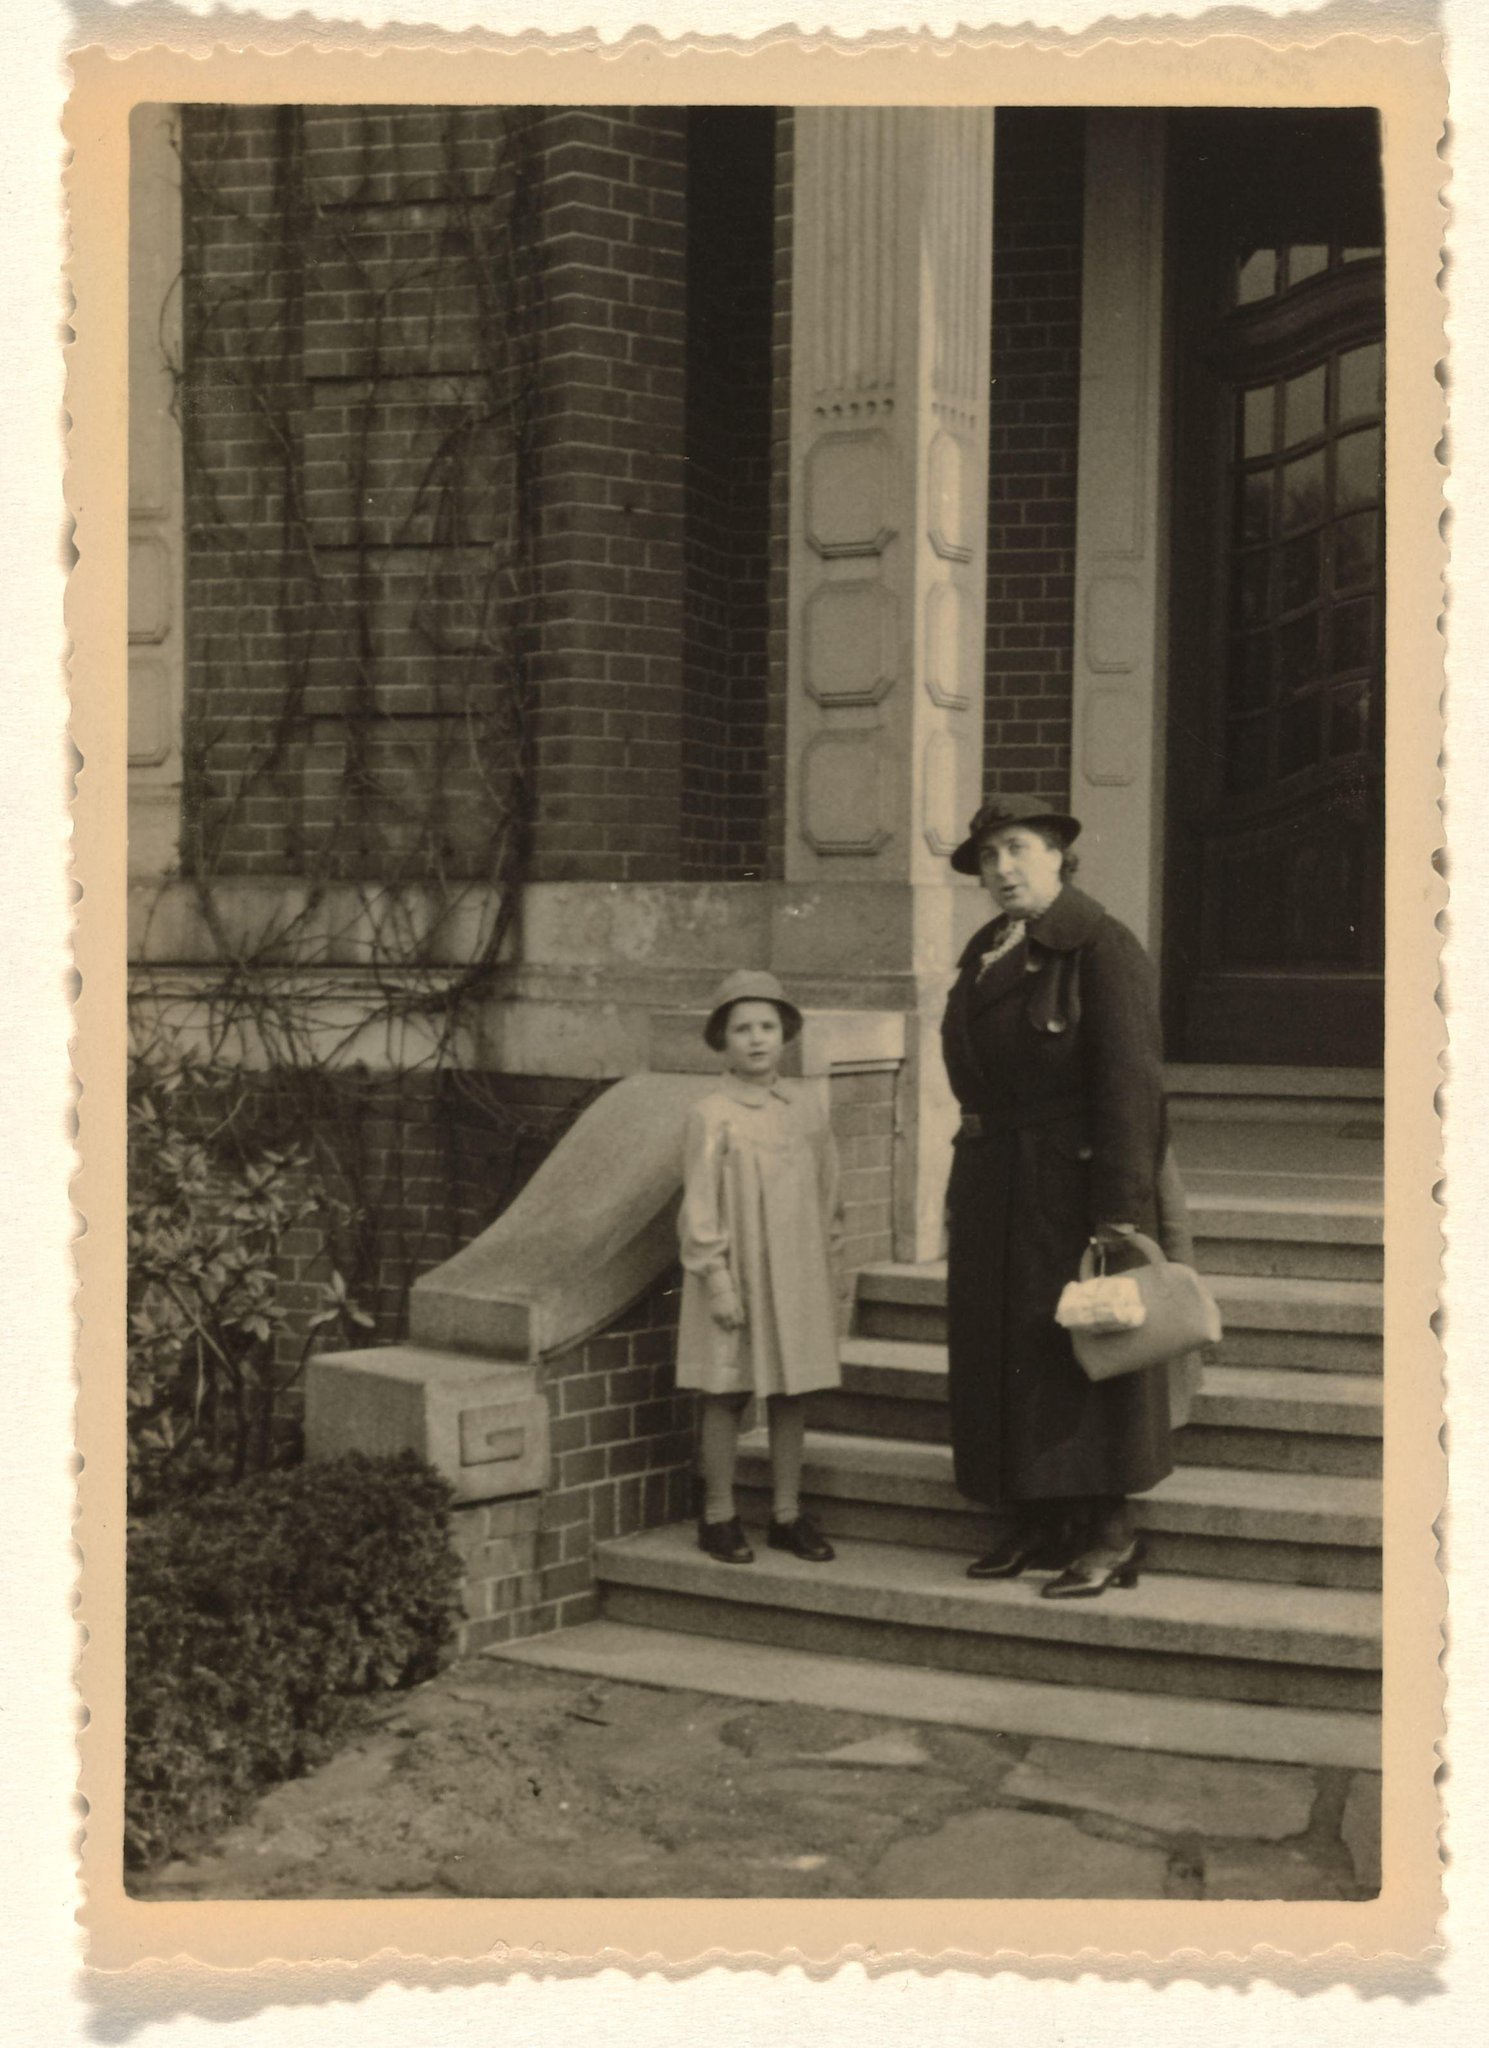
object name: photograph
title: Isabel Wachenheimer en Else Wachenheimer tijdens een bezoek aan Willy Moos in diens woning in Hamburg, Bellevue 62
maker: Anonymous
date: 1935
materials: photographic support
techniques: gelatin silver print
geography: hamburg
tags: else wachenheimer-moos, isabel wachenheimer-elon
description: Dit object is onderdeel van de nalatenschap van Isabel Elon-Wachenheimer (1928-2010). Tot haar overlijden behoorde het samen met de andere objecten uit de nalatenschap tot haar privédomein van Isabel Wachenheimer. In die particuliere context zijn deze objecten tezamen en individueel aandenkens - aan de jeugd, ouders en familie van Isabel Wachenheimer vóór en tijdens de Shoah en aan haar leven na de Tweede Wereldoorlog. Isabel Wachenheimer, die van juni 1943 tot mei 1945 gevangen zat in Kamp Westerbork, Theresienstadt, Auschwitz, Lenzing a/d Oberdonau (een buitenkamp van Mauthausen), overleefde de Shoah. Haar ouders – Eugène Wachenheimer en Else Wachenheimer-Moos - werden op 14 oktober 1944 in Auschwitz-Birkenau vermoord.